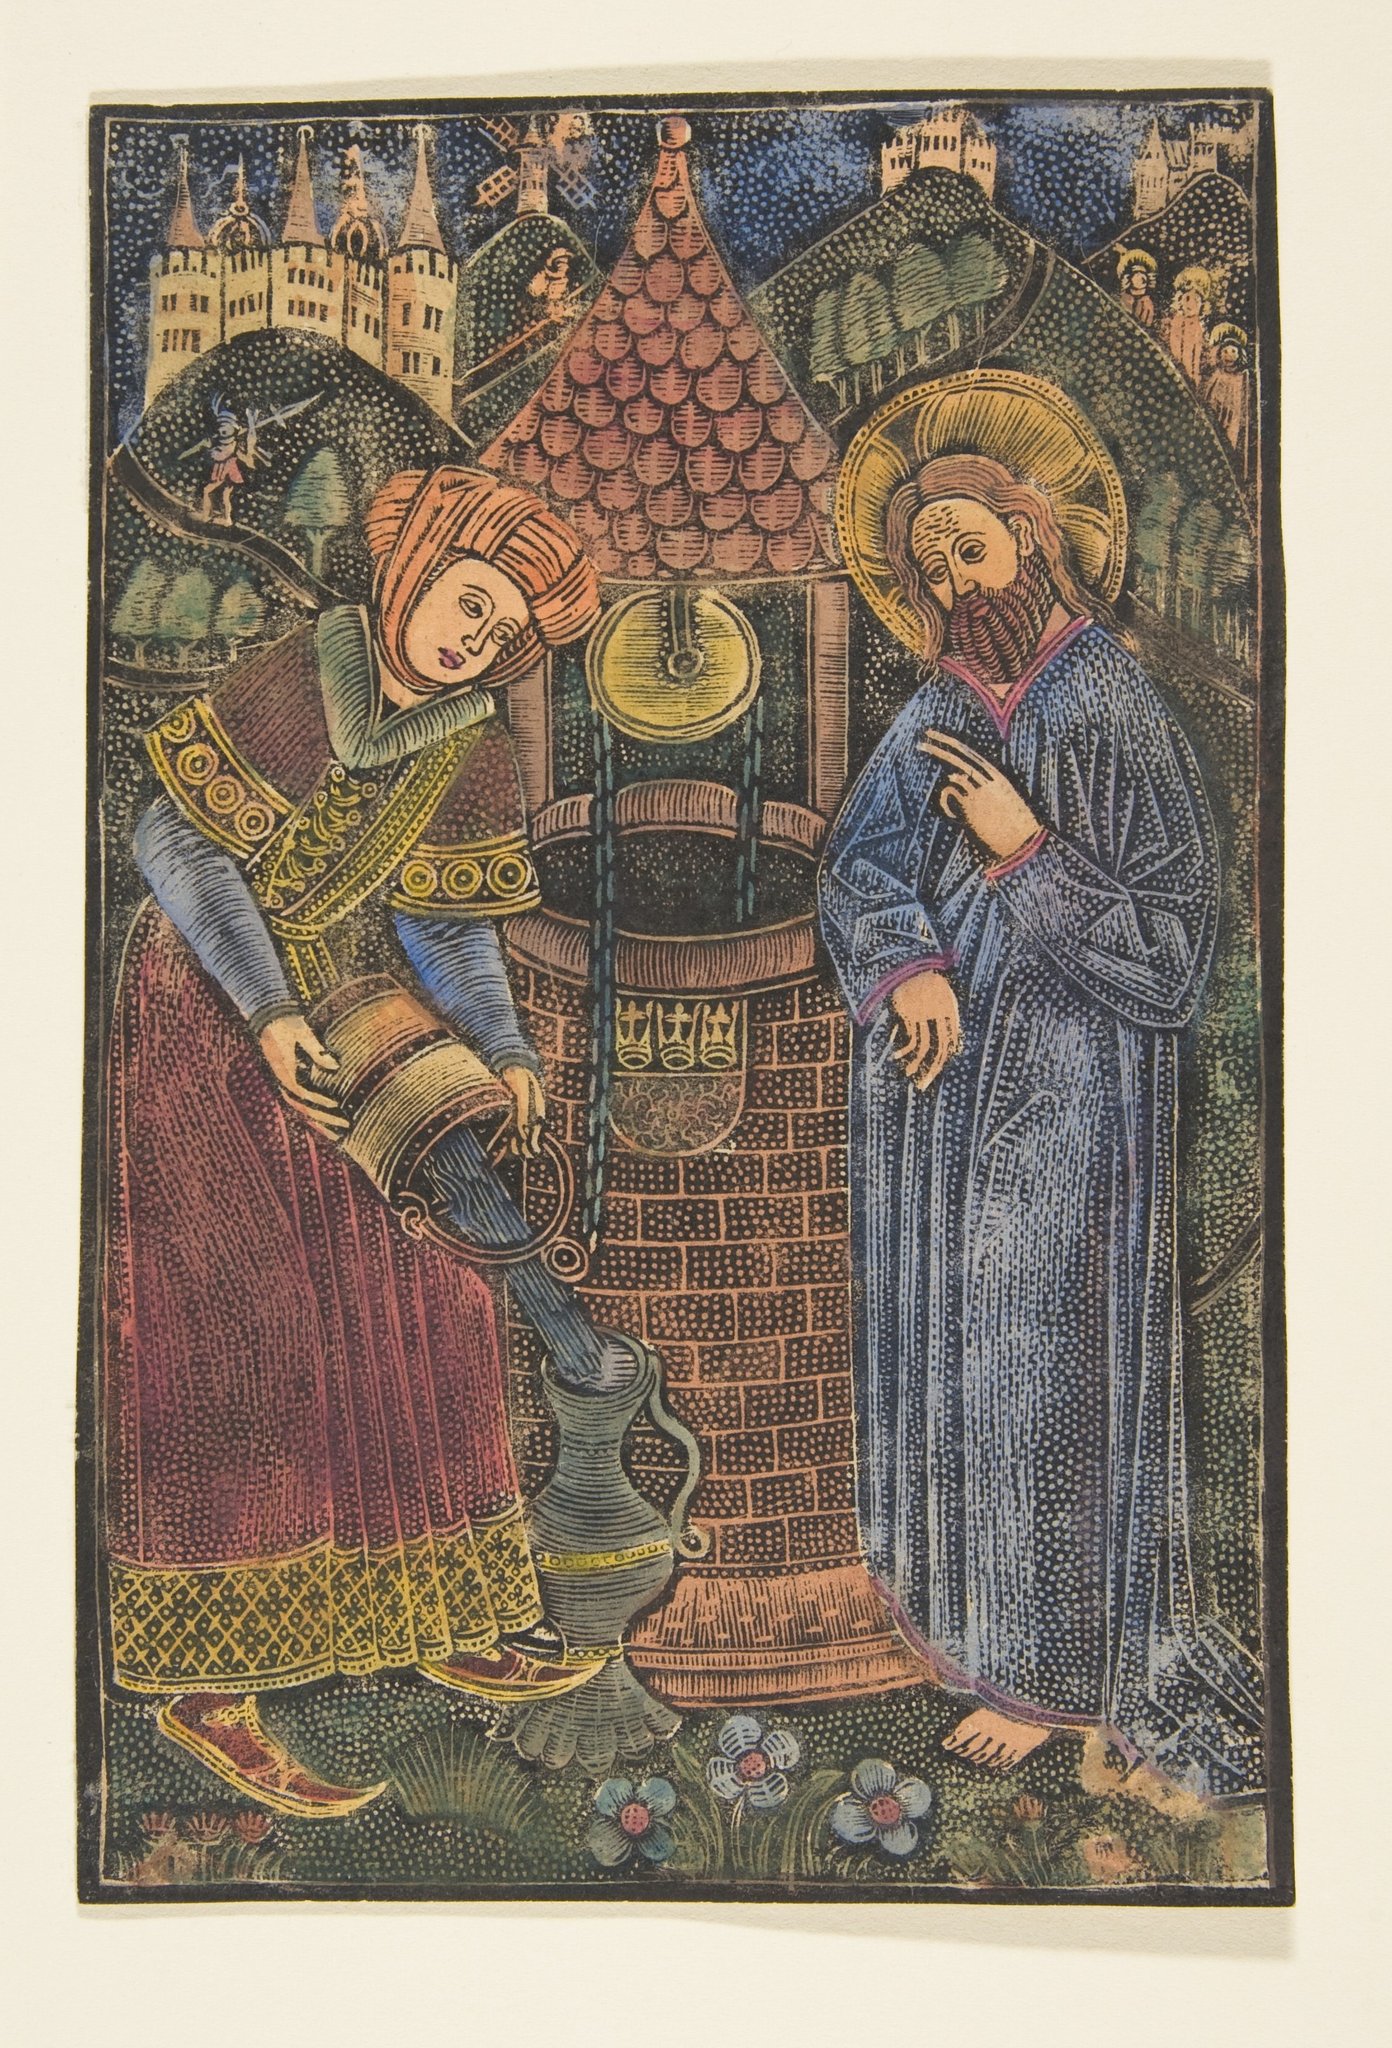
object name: print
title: Christ and the Woman of Samaria (Schr. 2215)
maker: master with the cologne arms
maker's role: artist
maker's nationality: german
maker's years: 1450-1500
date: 1460-1470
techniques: hand coloring, printing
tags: wells,women,christ